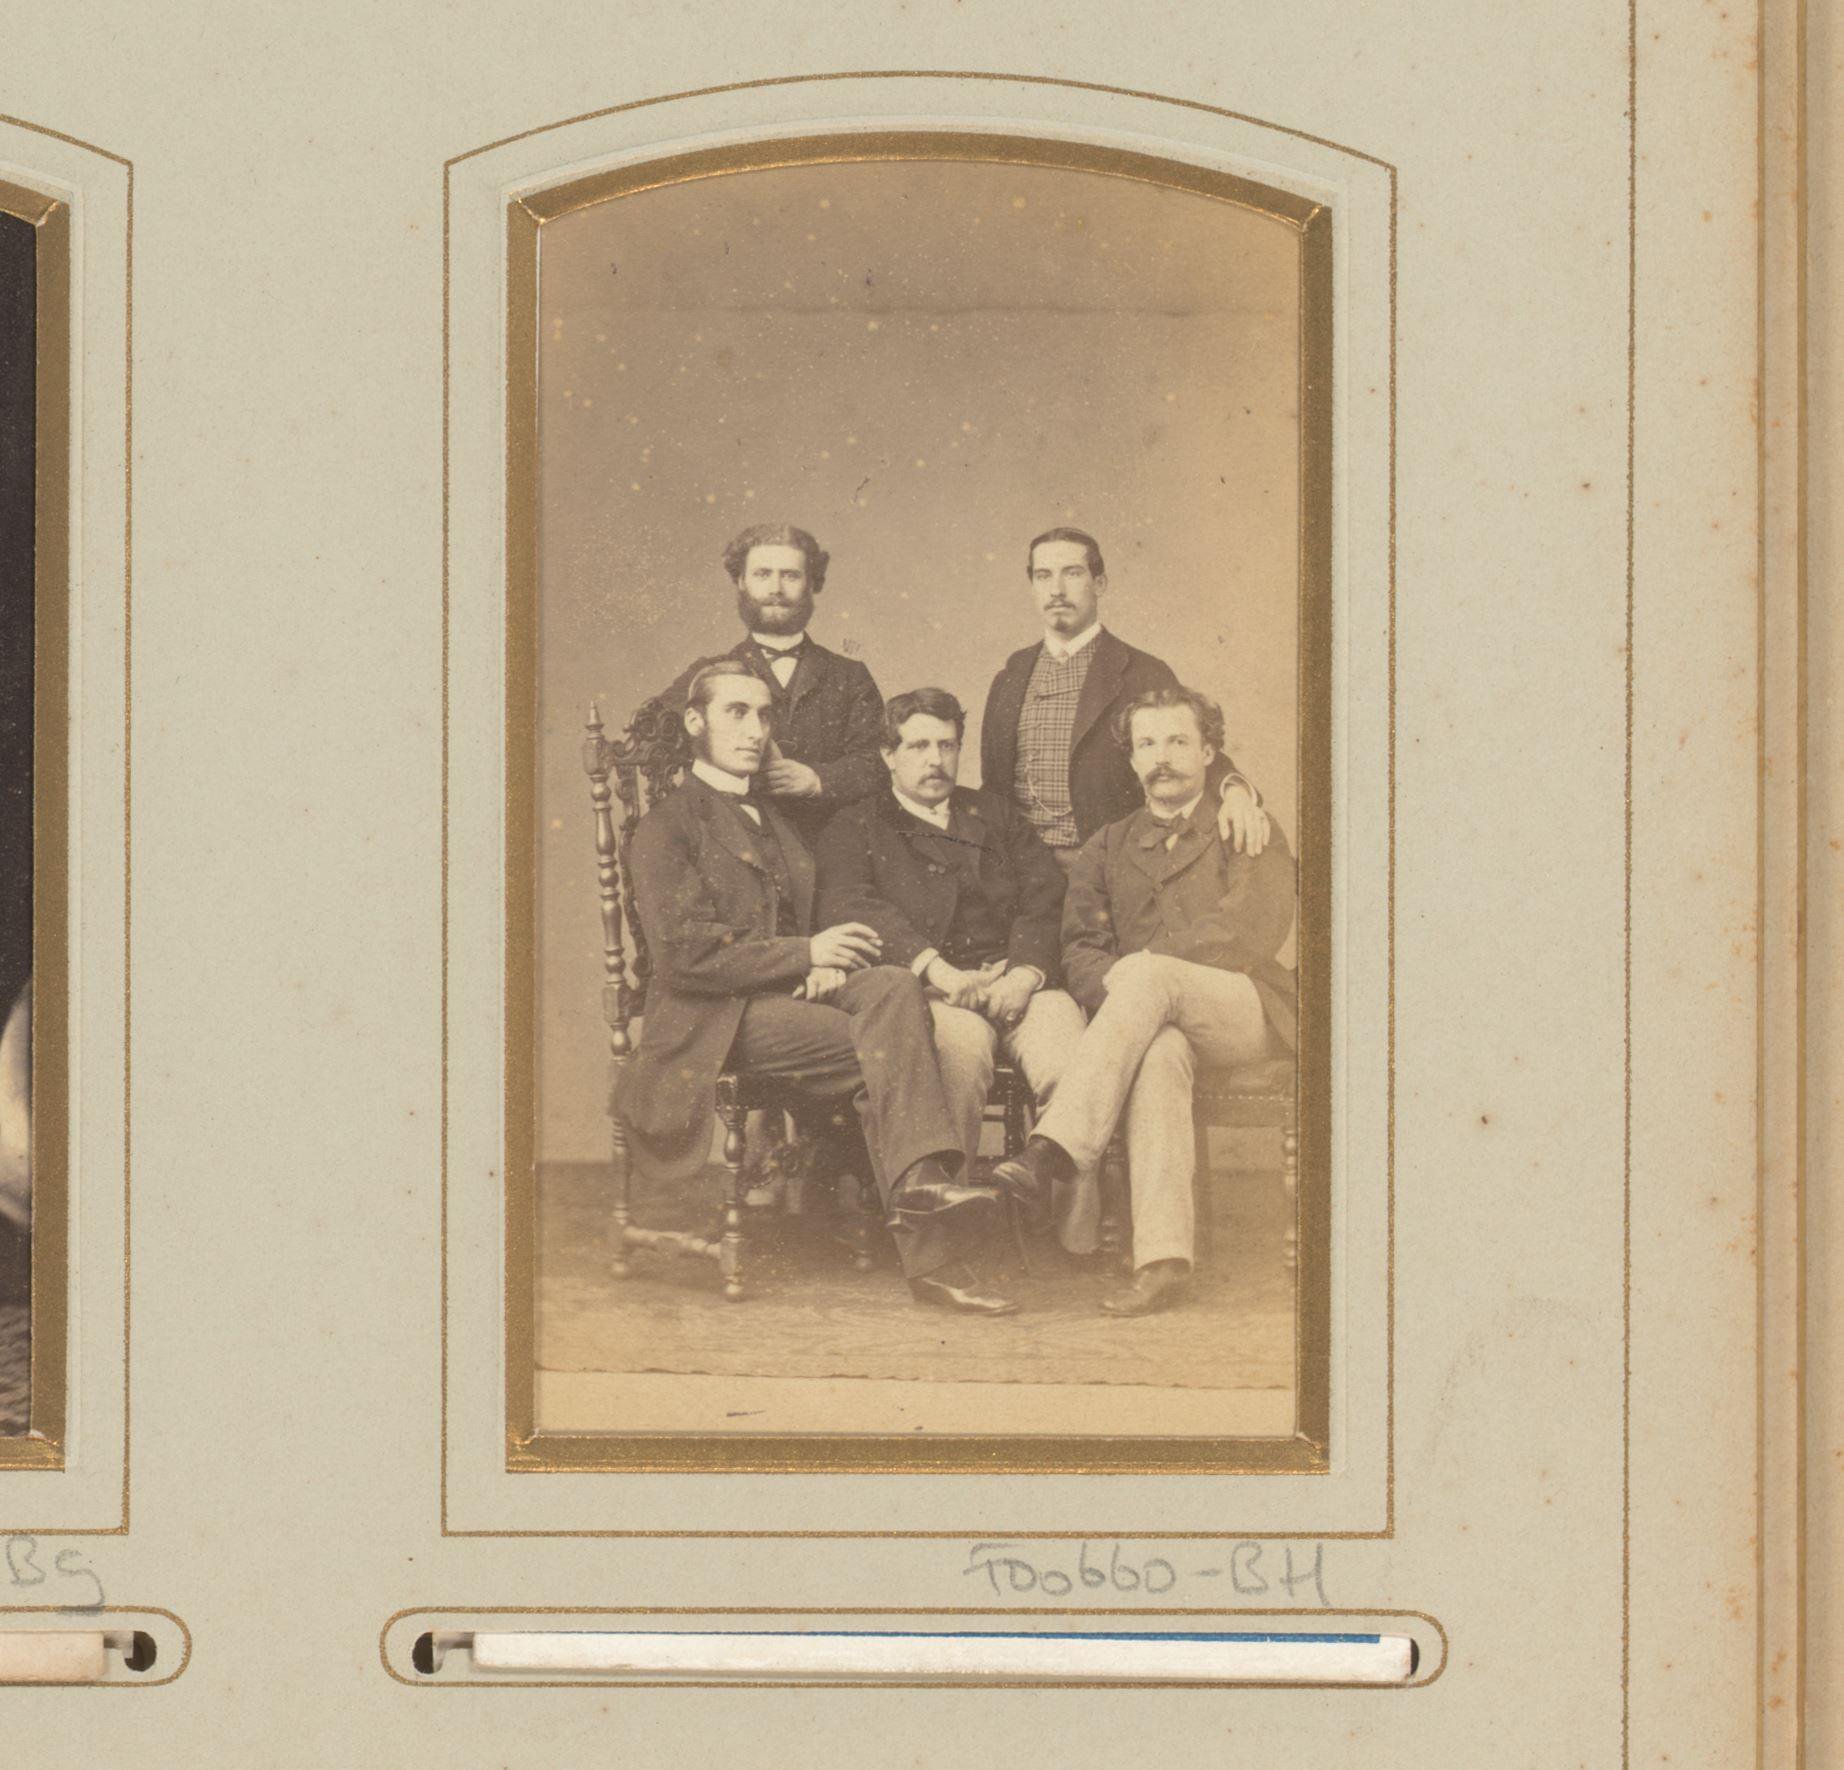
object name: album leaf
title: Groepsportret van vijf mannen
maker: joseph maes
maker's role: fotograaf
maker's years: 1838-1908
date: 1880-1890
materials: cardboard, photographic support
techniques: albumen print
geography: antwerp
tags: adult man (+ five persons), anonymous historical persons portrayed in a group, in a group-portrait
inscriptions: inscription: ‘Photographie/ Maes/ 1, Rue des Aveugles, 1/ PLACE DU MUSÉE/ Anvers’